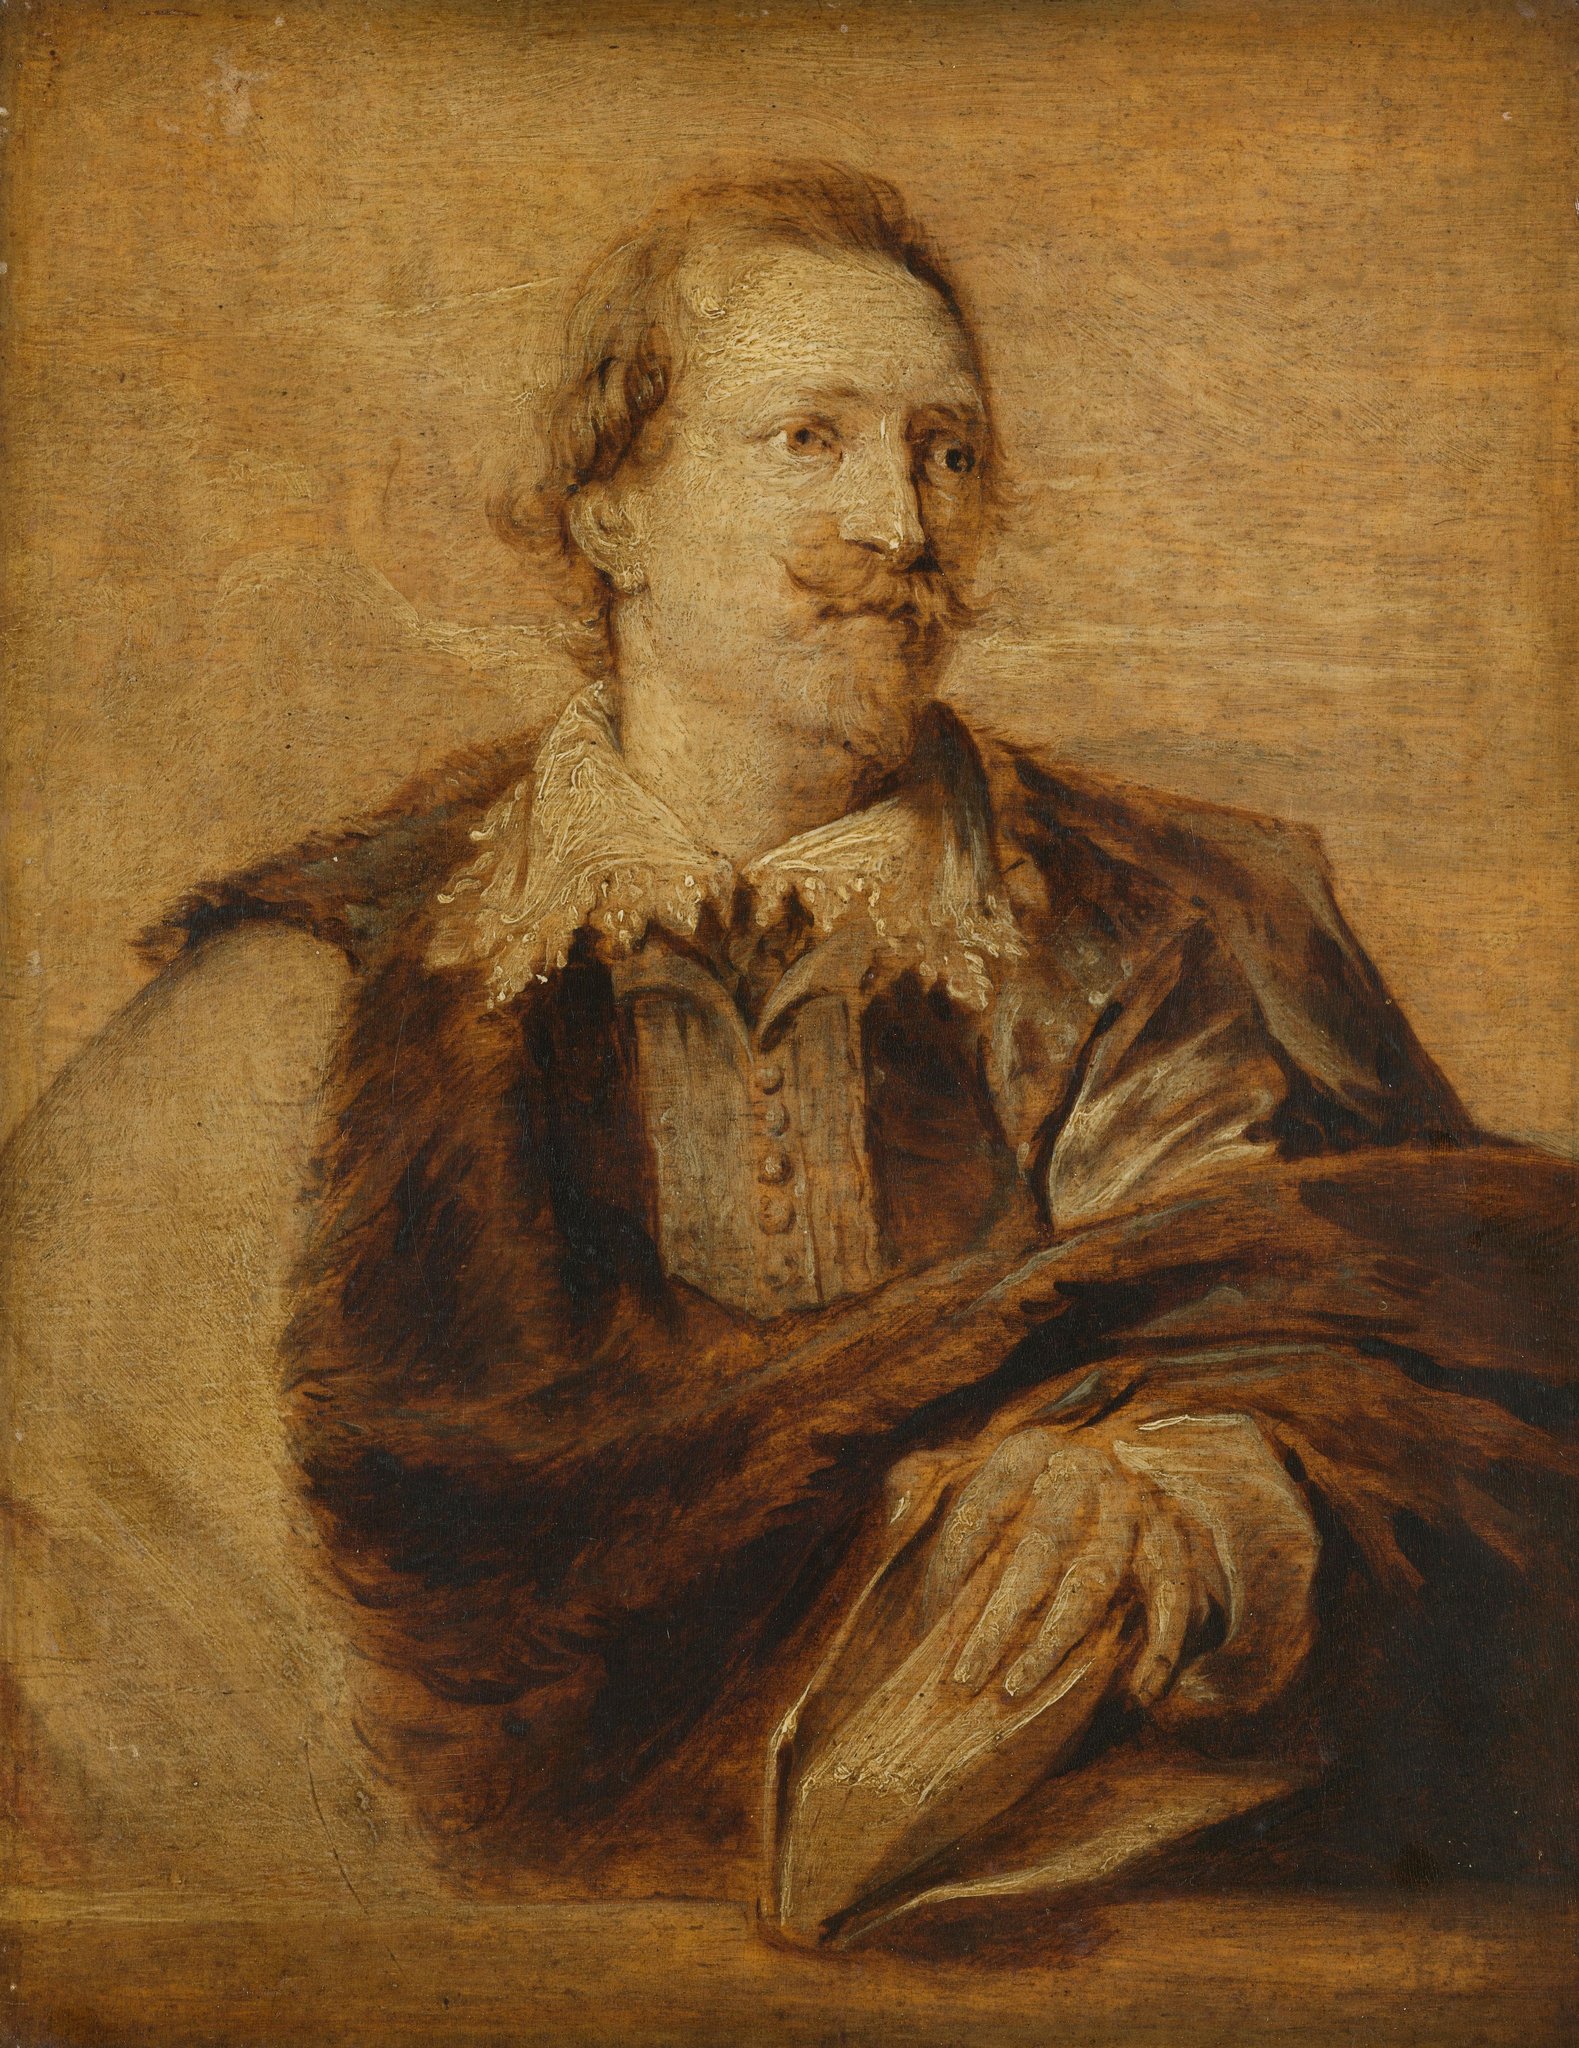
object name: grisaille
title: Portrait of Jan Gaspar Gevaerts (1593-1666)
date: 1630-1650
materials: oil, panel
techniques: grisaille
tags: politician, jean gaspard gevartius, scholar, philosopher, historical persons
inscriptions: inscription, indistinct, on the reverse: ‘[Casperus Gevaerts]’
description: Portret van Jan Caspar Gevaerts, rechtsgeleerde, geschiedschrijver, filosoof en dichter. Ten halven lijve, een boek in de linkerhand.